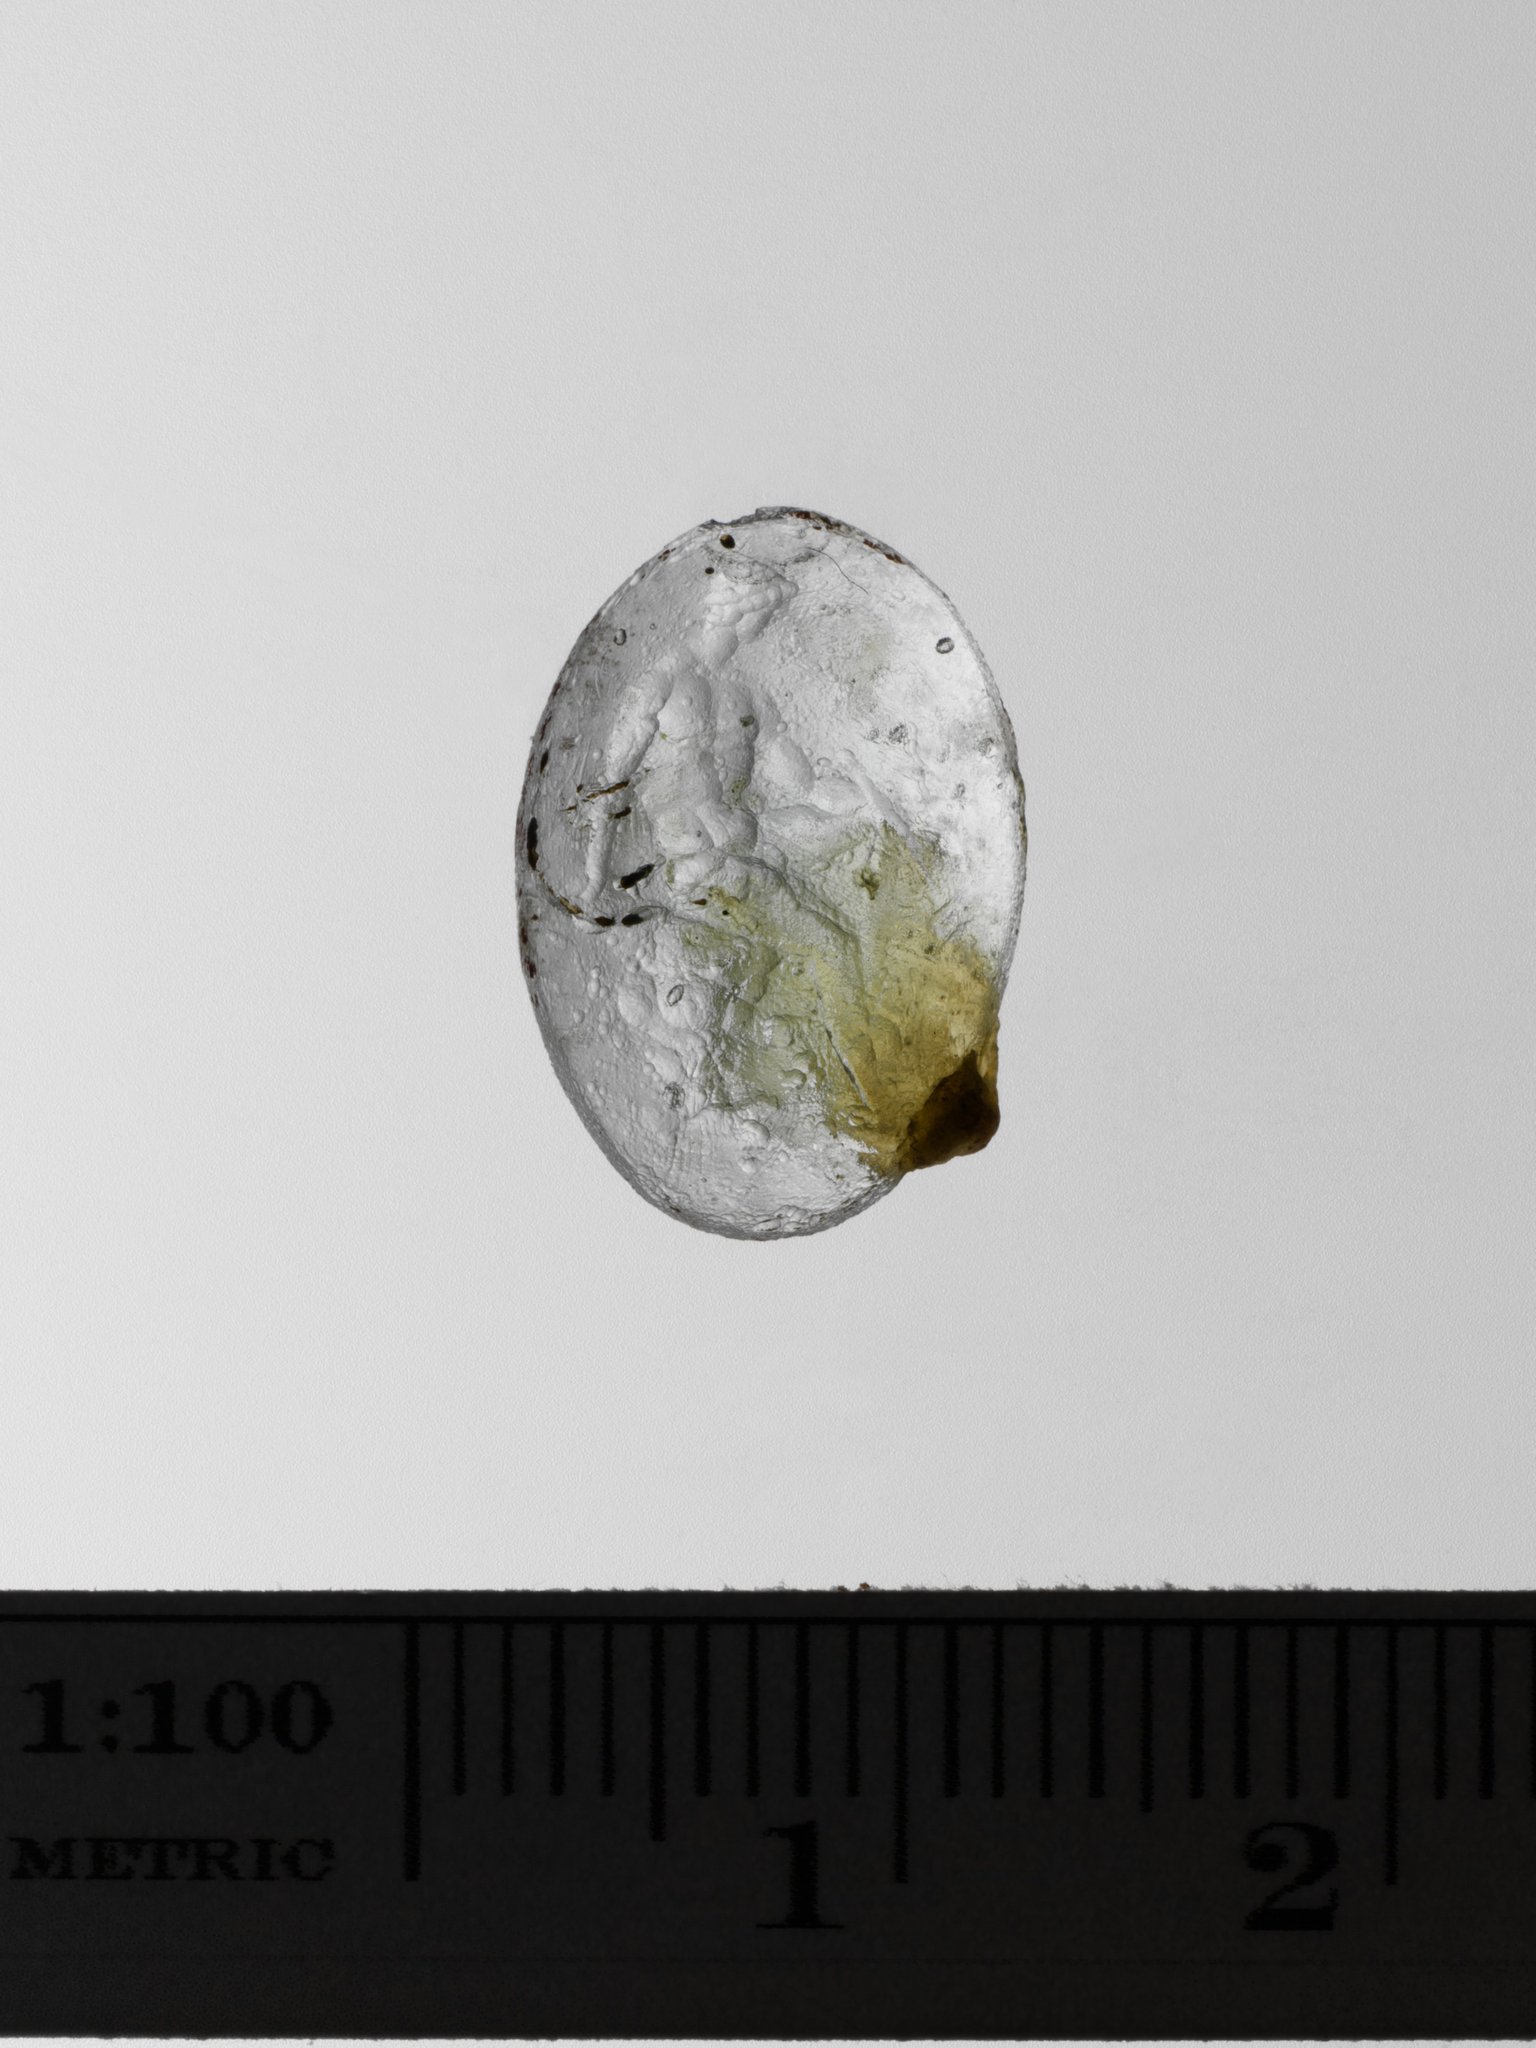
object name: intaglio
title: Colorless glass ring stone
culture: roman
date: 1-100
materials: glass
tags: hermes